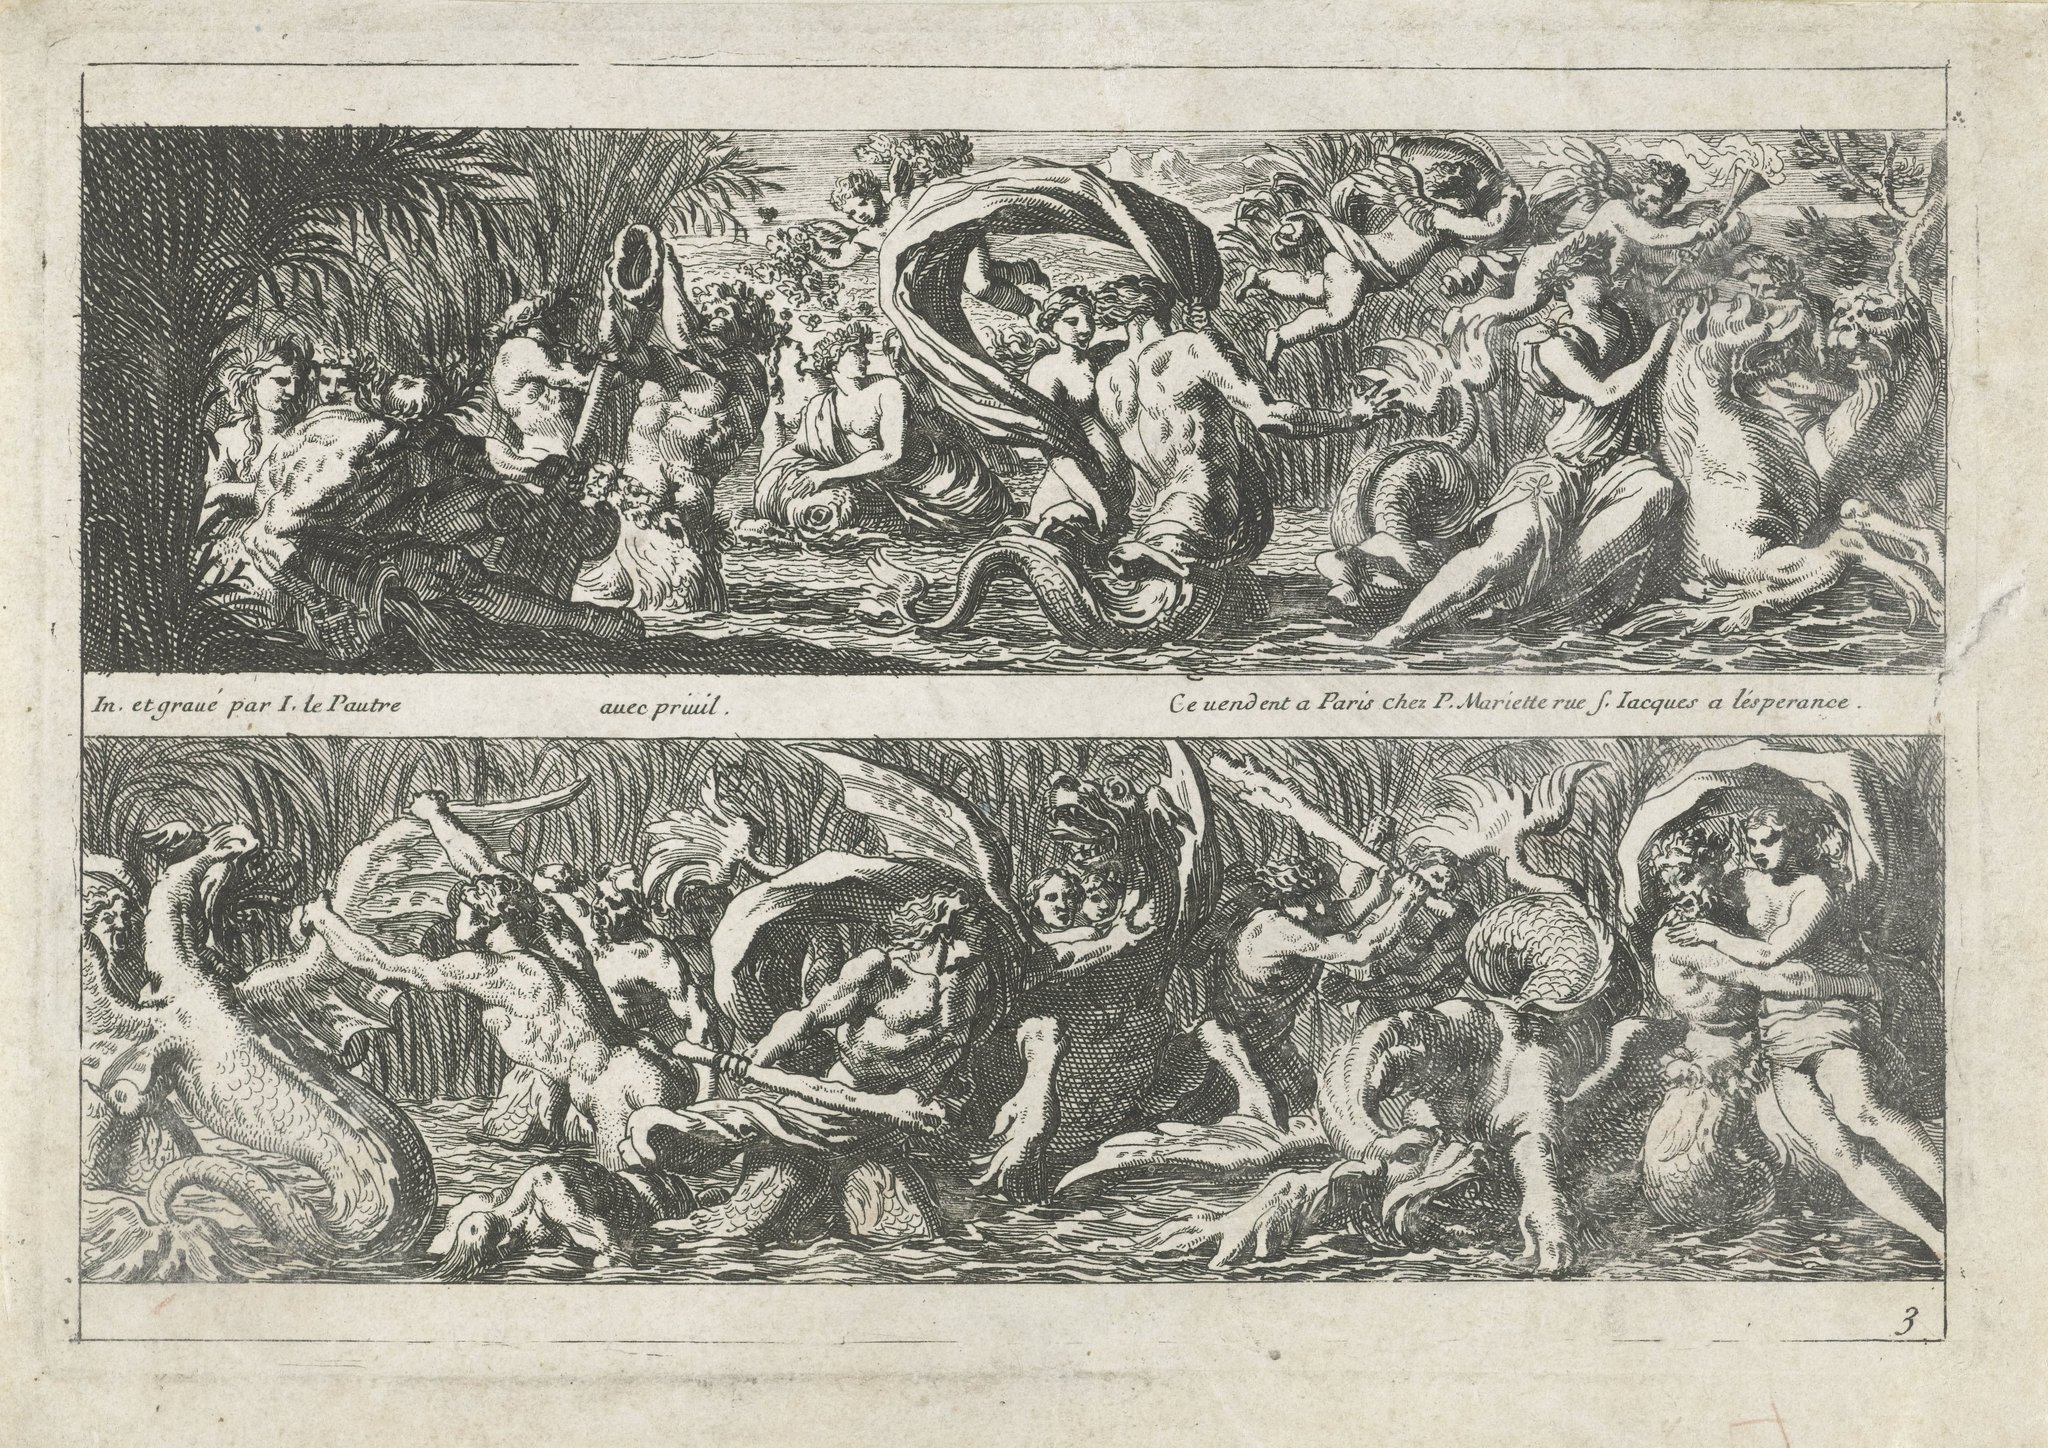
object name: print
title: Twee friezen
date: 1664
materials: paper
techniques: etching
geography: france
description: Friezen met bladranken en tritons in Romeinse stijl. Blad uit tweede editie.